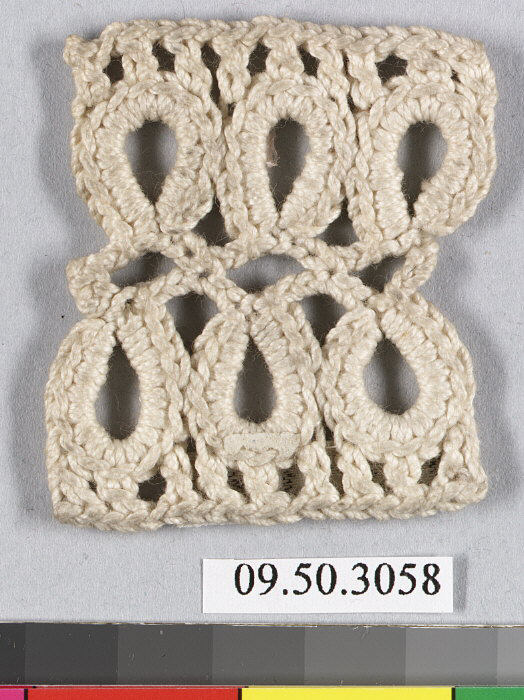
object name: sample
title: Crochet Work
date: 1801-1900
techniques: crochet